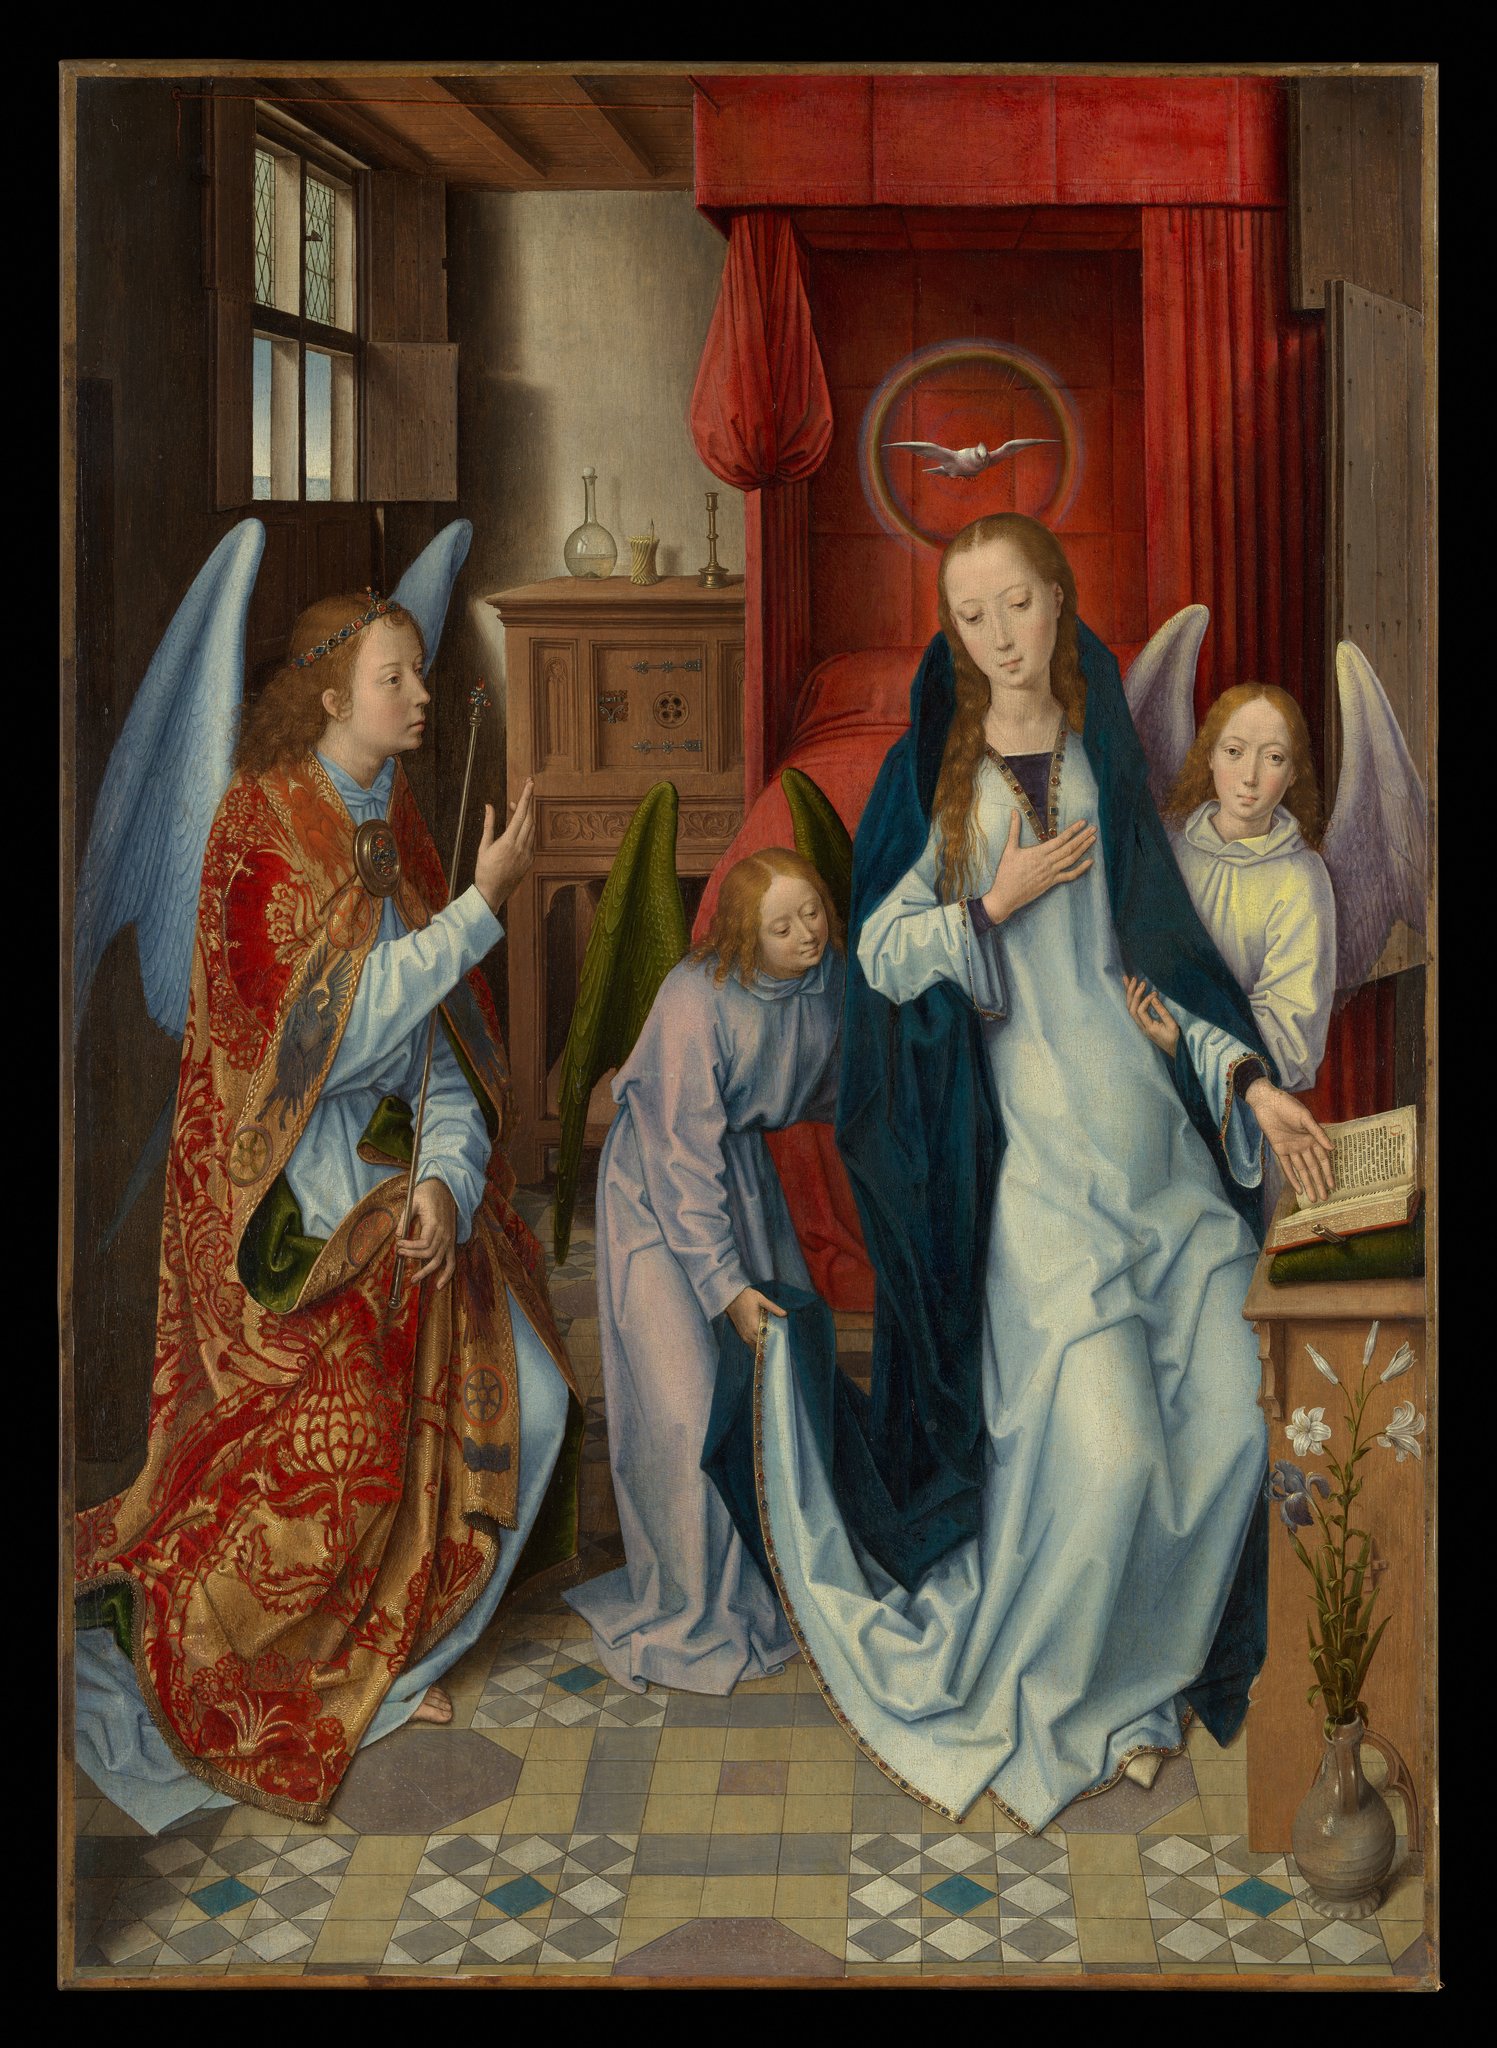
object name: painting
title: The Annunciation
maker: hans memling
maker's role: artist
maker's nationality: netherlandish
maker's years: 1465-1494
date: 1480-1489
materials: canvas, oil, panel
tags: bedrooms,angels,virgin mary,archangel gabriel,annunciation